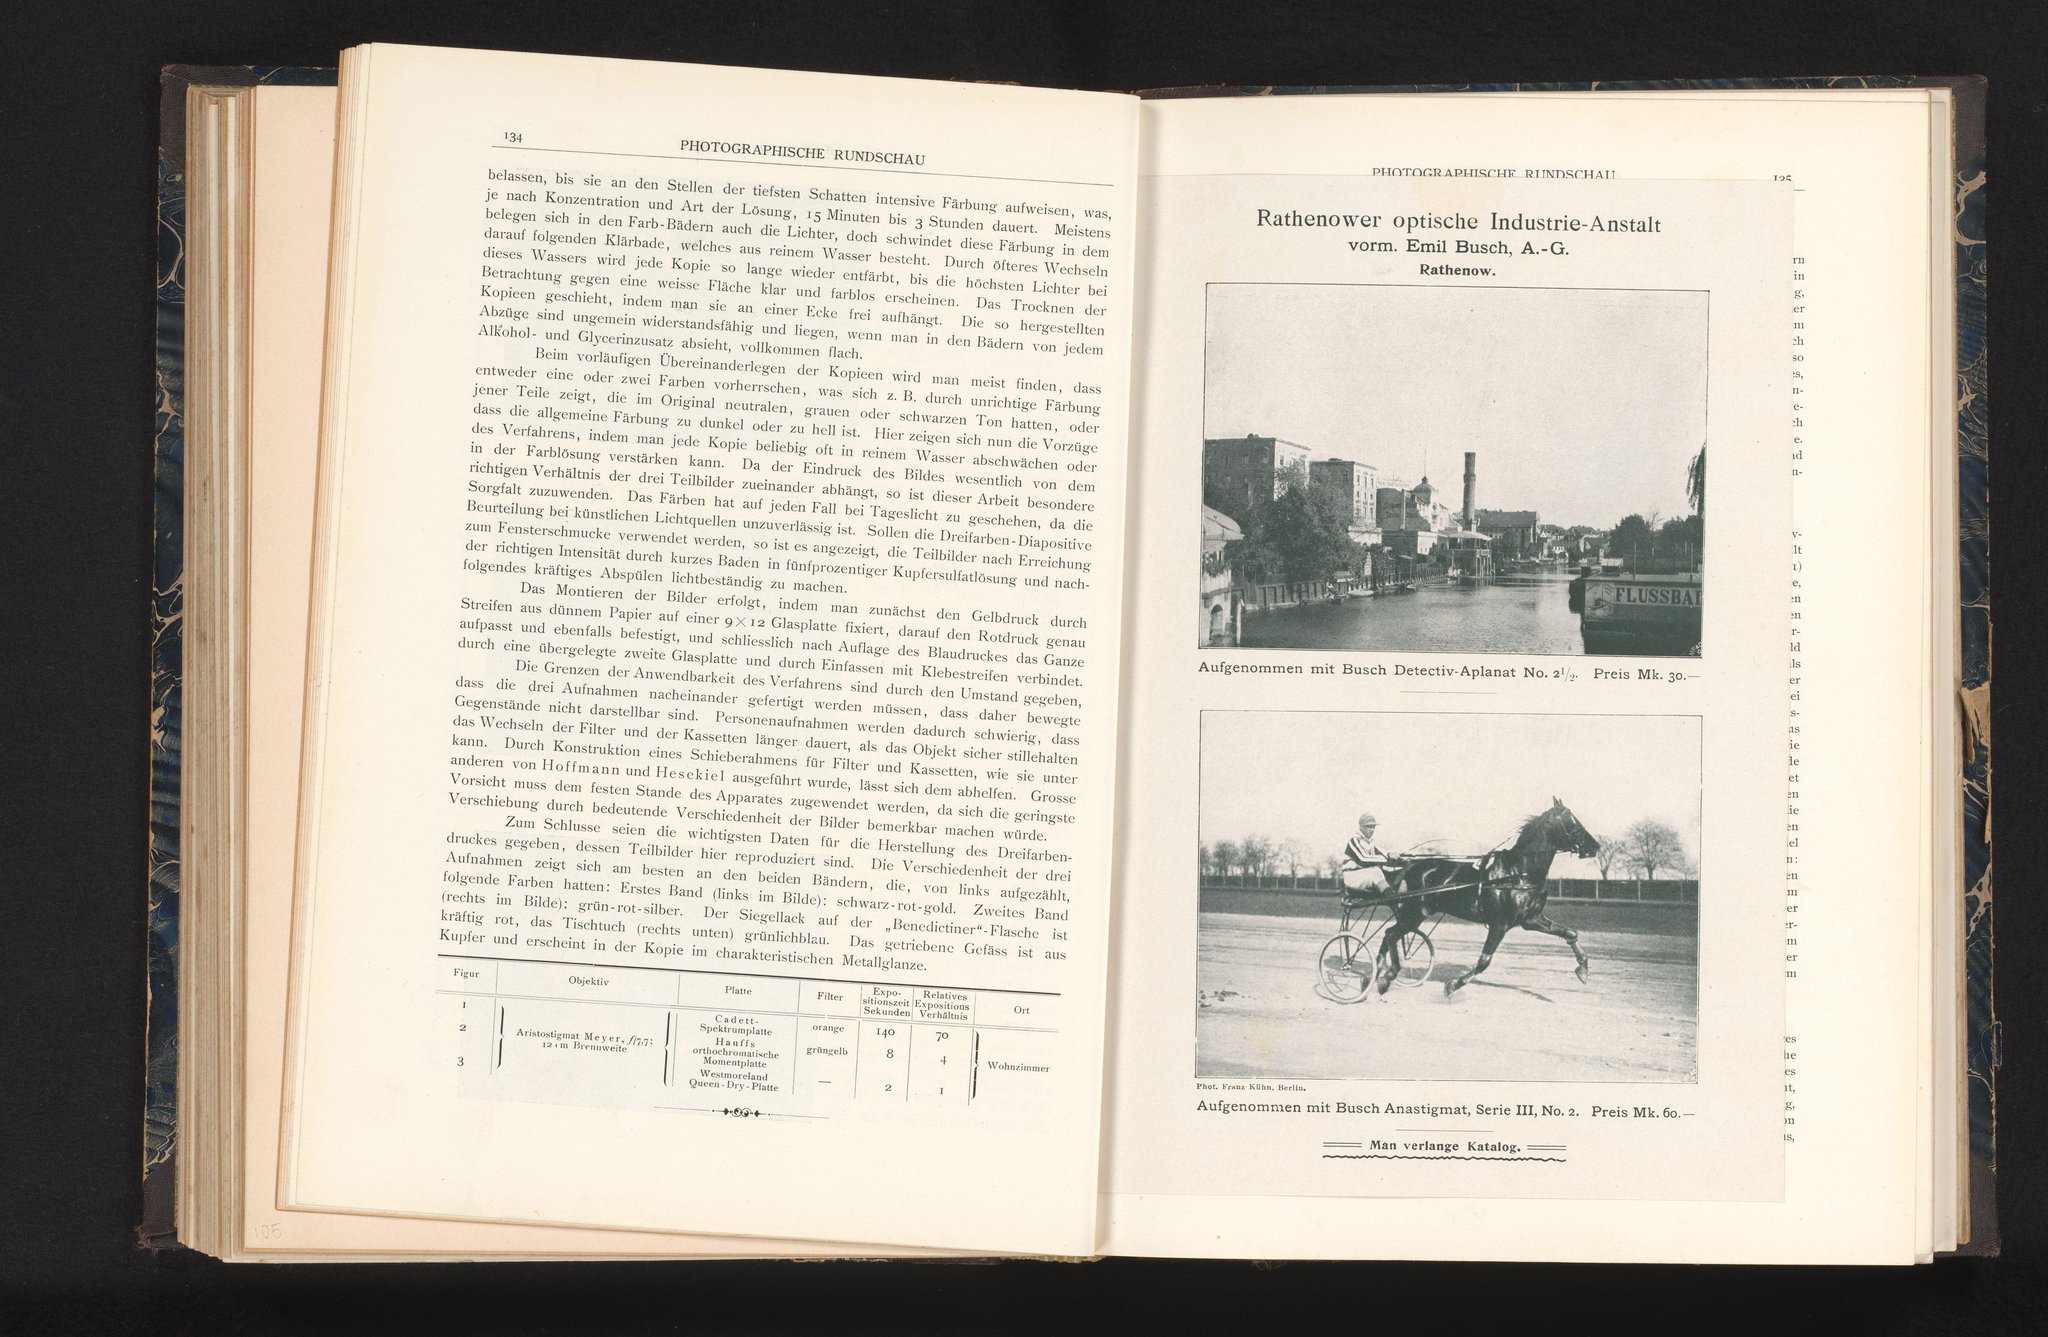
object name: page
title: Gezicht op een rivier met daaraan gebouwen en een schoorsteen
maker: Anonymous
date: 1897-1902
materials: paper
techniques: autotype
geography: berlin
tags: canals, waters (in city)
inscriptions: inscription: ‘Rathenower optische Industrie-Anstalt/ vorm. Emil Busch (...)’